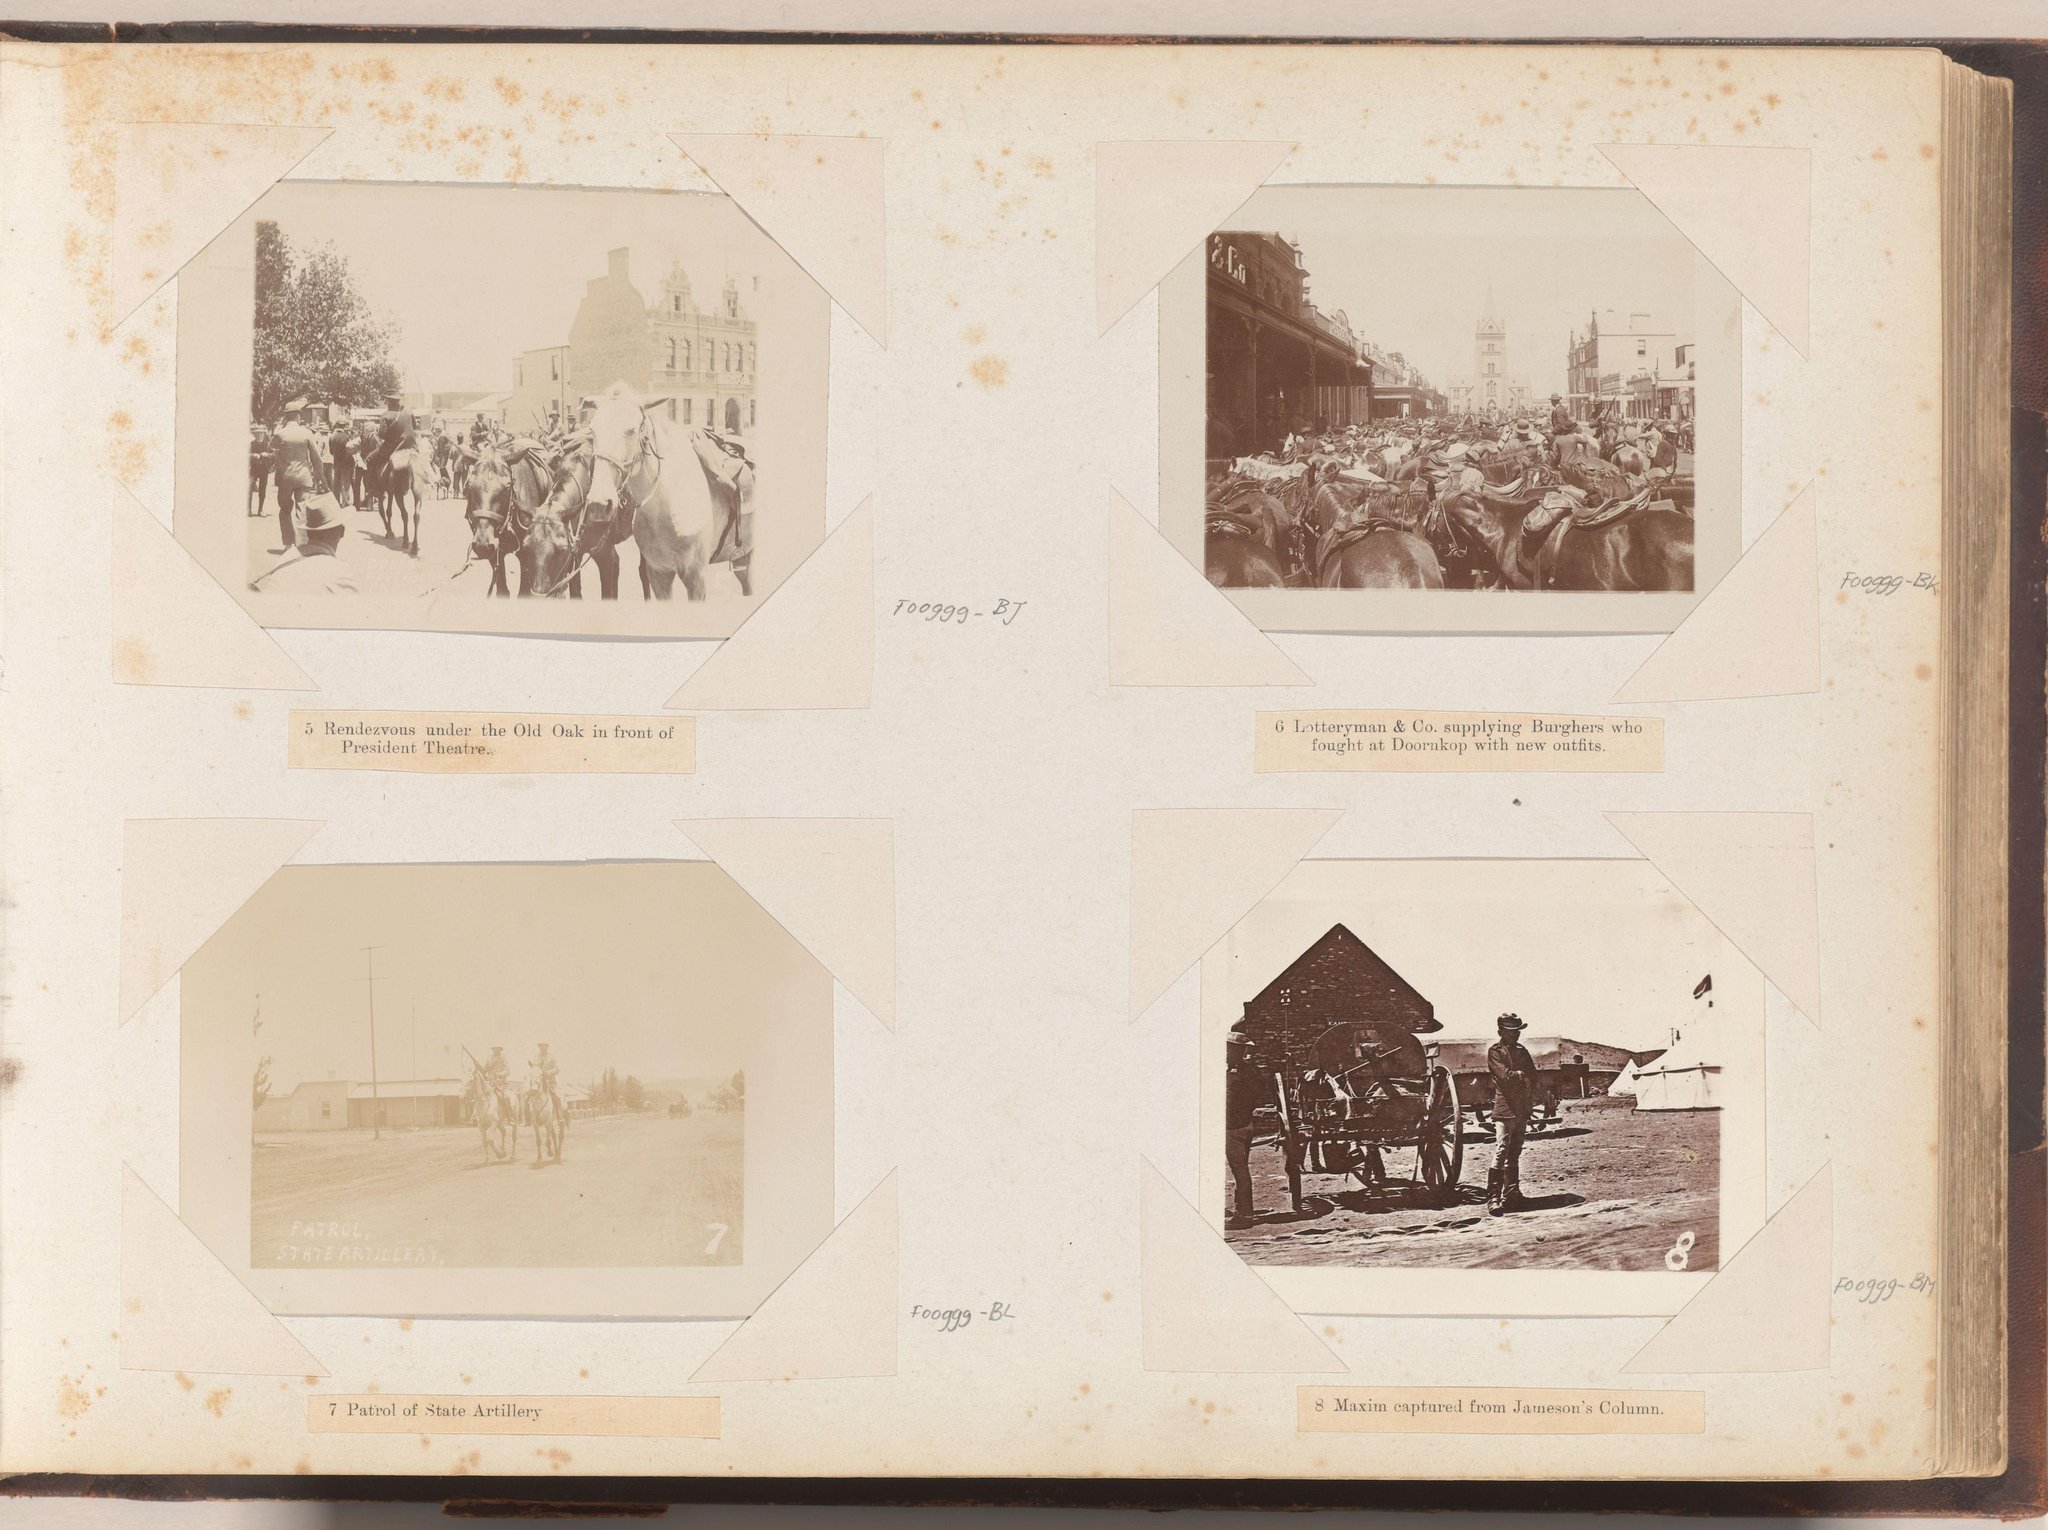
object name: photograph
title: Rendezvous under the Old Oak in front of President Theatre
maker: Anonymous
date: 1896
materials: paper, photographic support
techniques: gelatin silver print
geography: pretoria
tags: land forces (+ cavalry, horsemen)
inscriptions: inscription: ‘Boers assembling Pretoria. 5’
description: Onderdeel van Album met 191 foto's van een reis naar en door Zuid-Afrika.